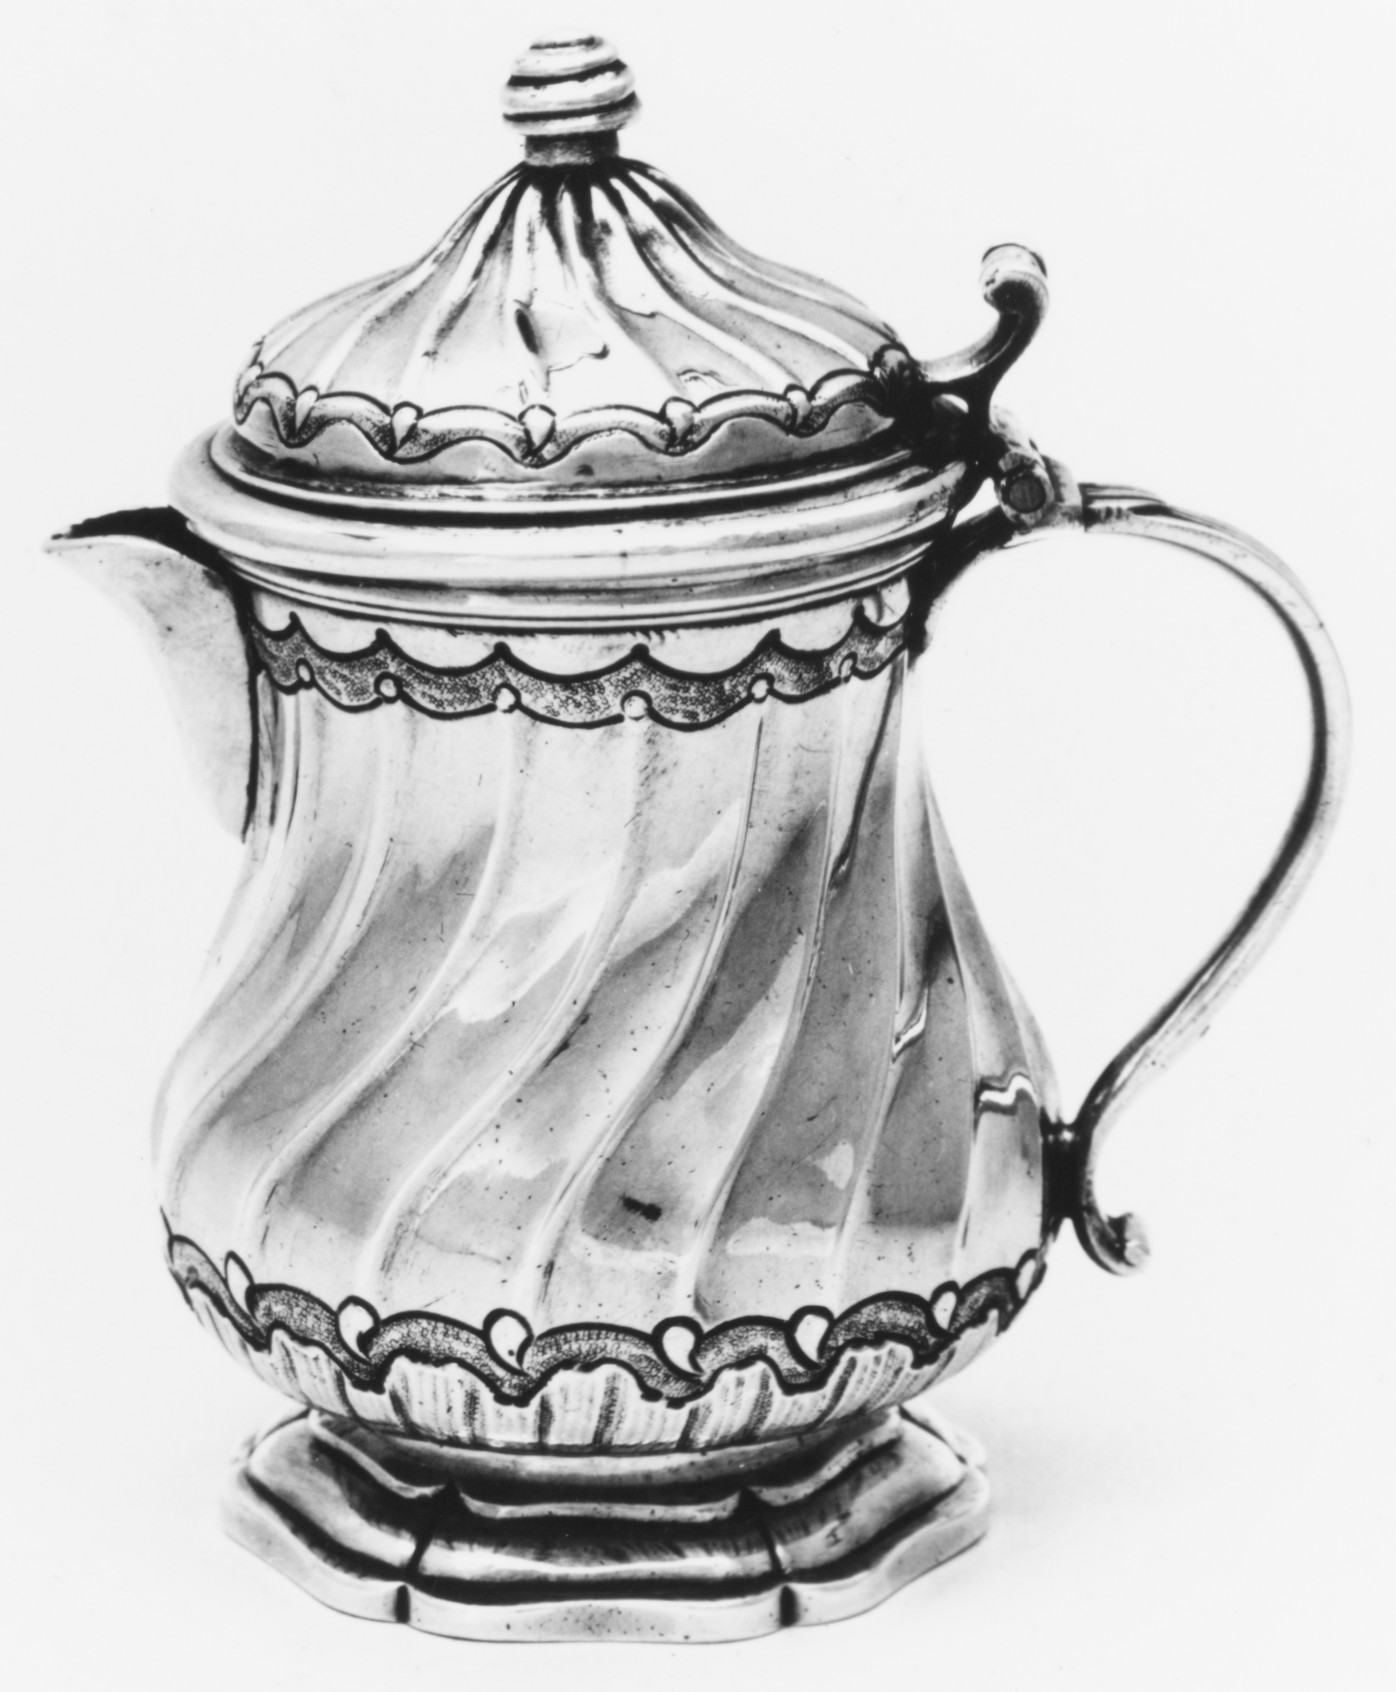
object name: mustard pot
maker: ennemond ruynat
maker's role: maker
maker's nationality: french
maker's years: 1715-1778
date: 1753-1754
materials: silver